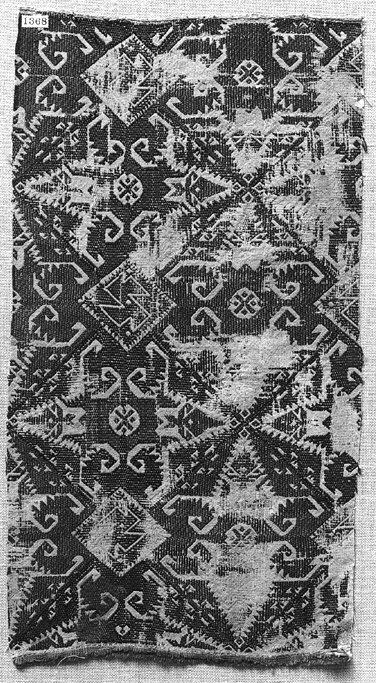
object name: fragment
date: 1701-1800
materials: linen, silk